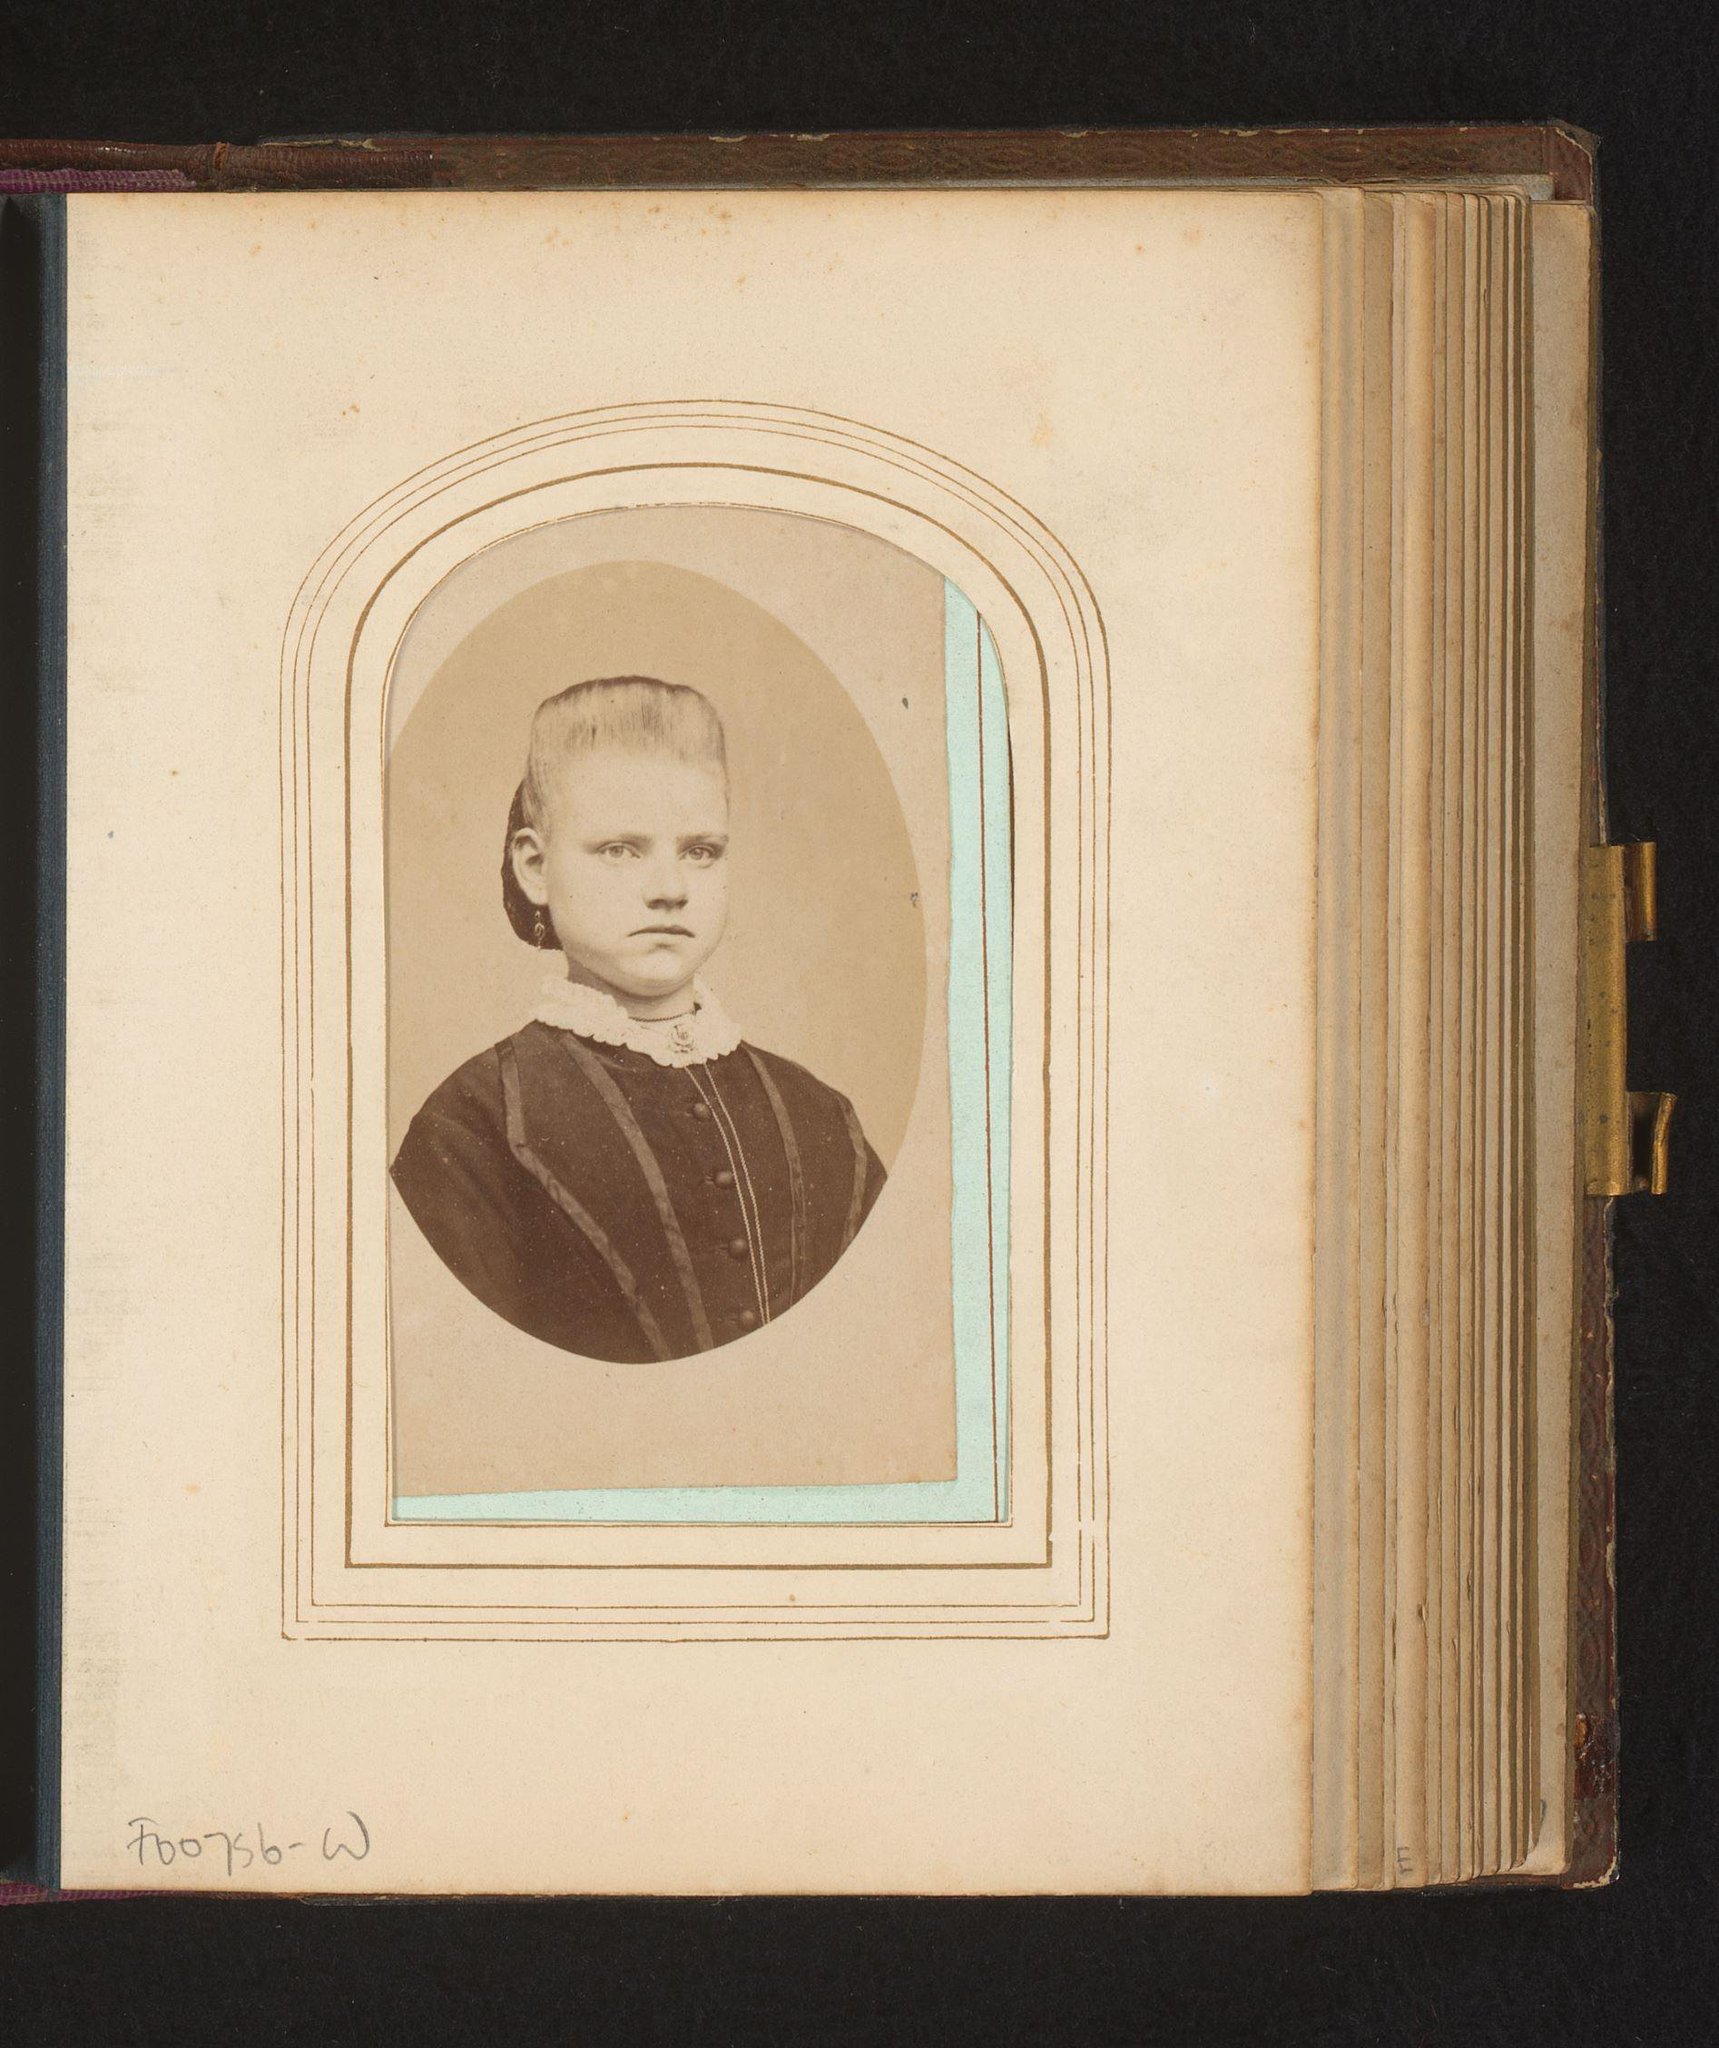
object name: photograph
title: Portret van een meisje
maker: benjamin sanders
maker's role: fotograaf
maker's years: 1841-1889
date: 1860-1890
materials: cardboard, photographic support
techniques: albumen print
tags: historical persons - bb - woman, girl (child between toddler and youth)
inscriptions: inscription: ‘Nieuwe Ebbingestraat Groningen’